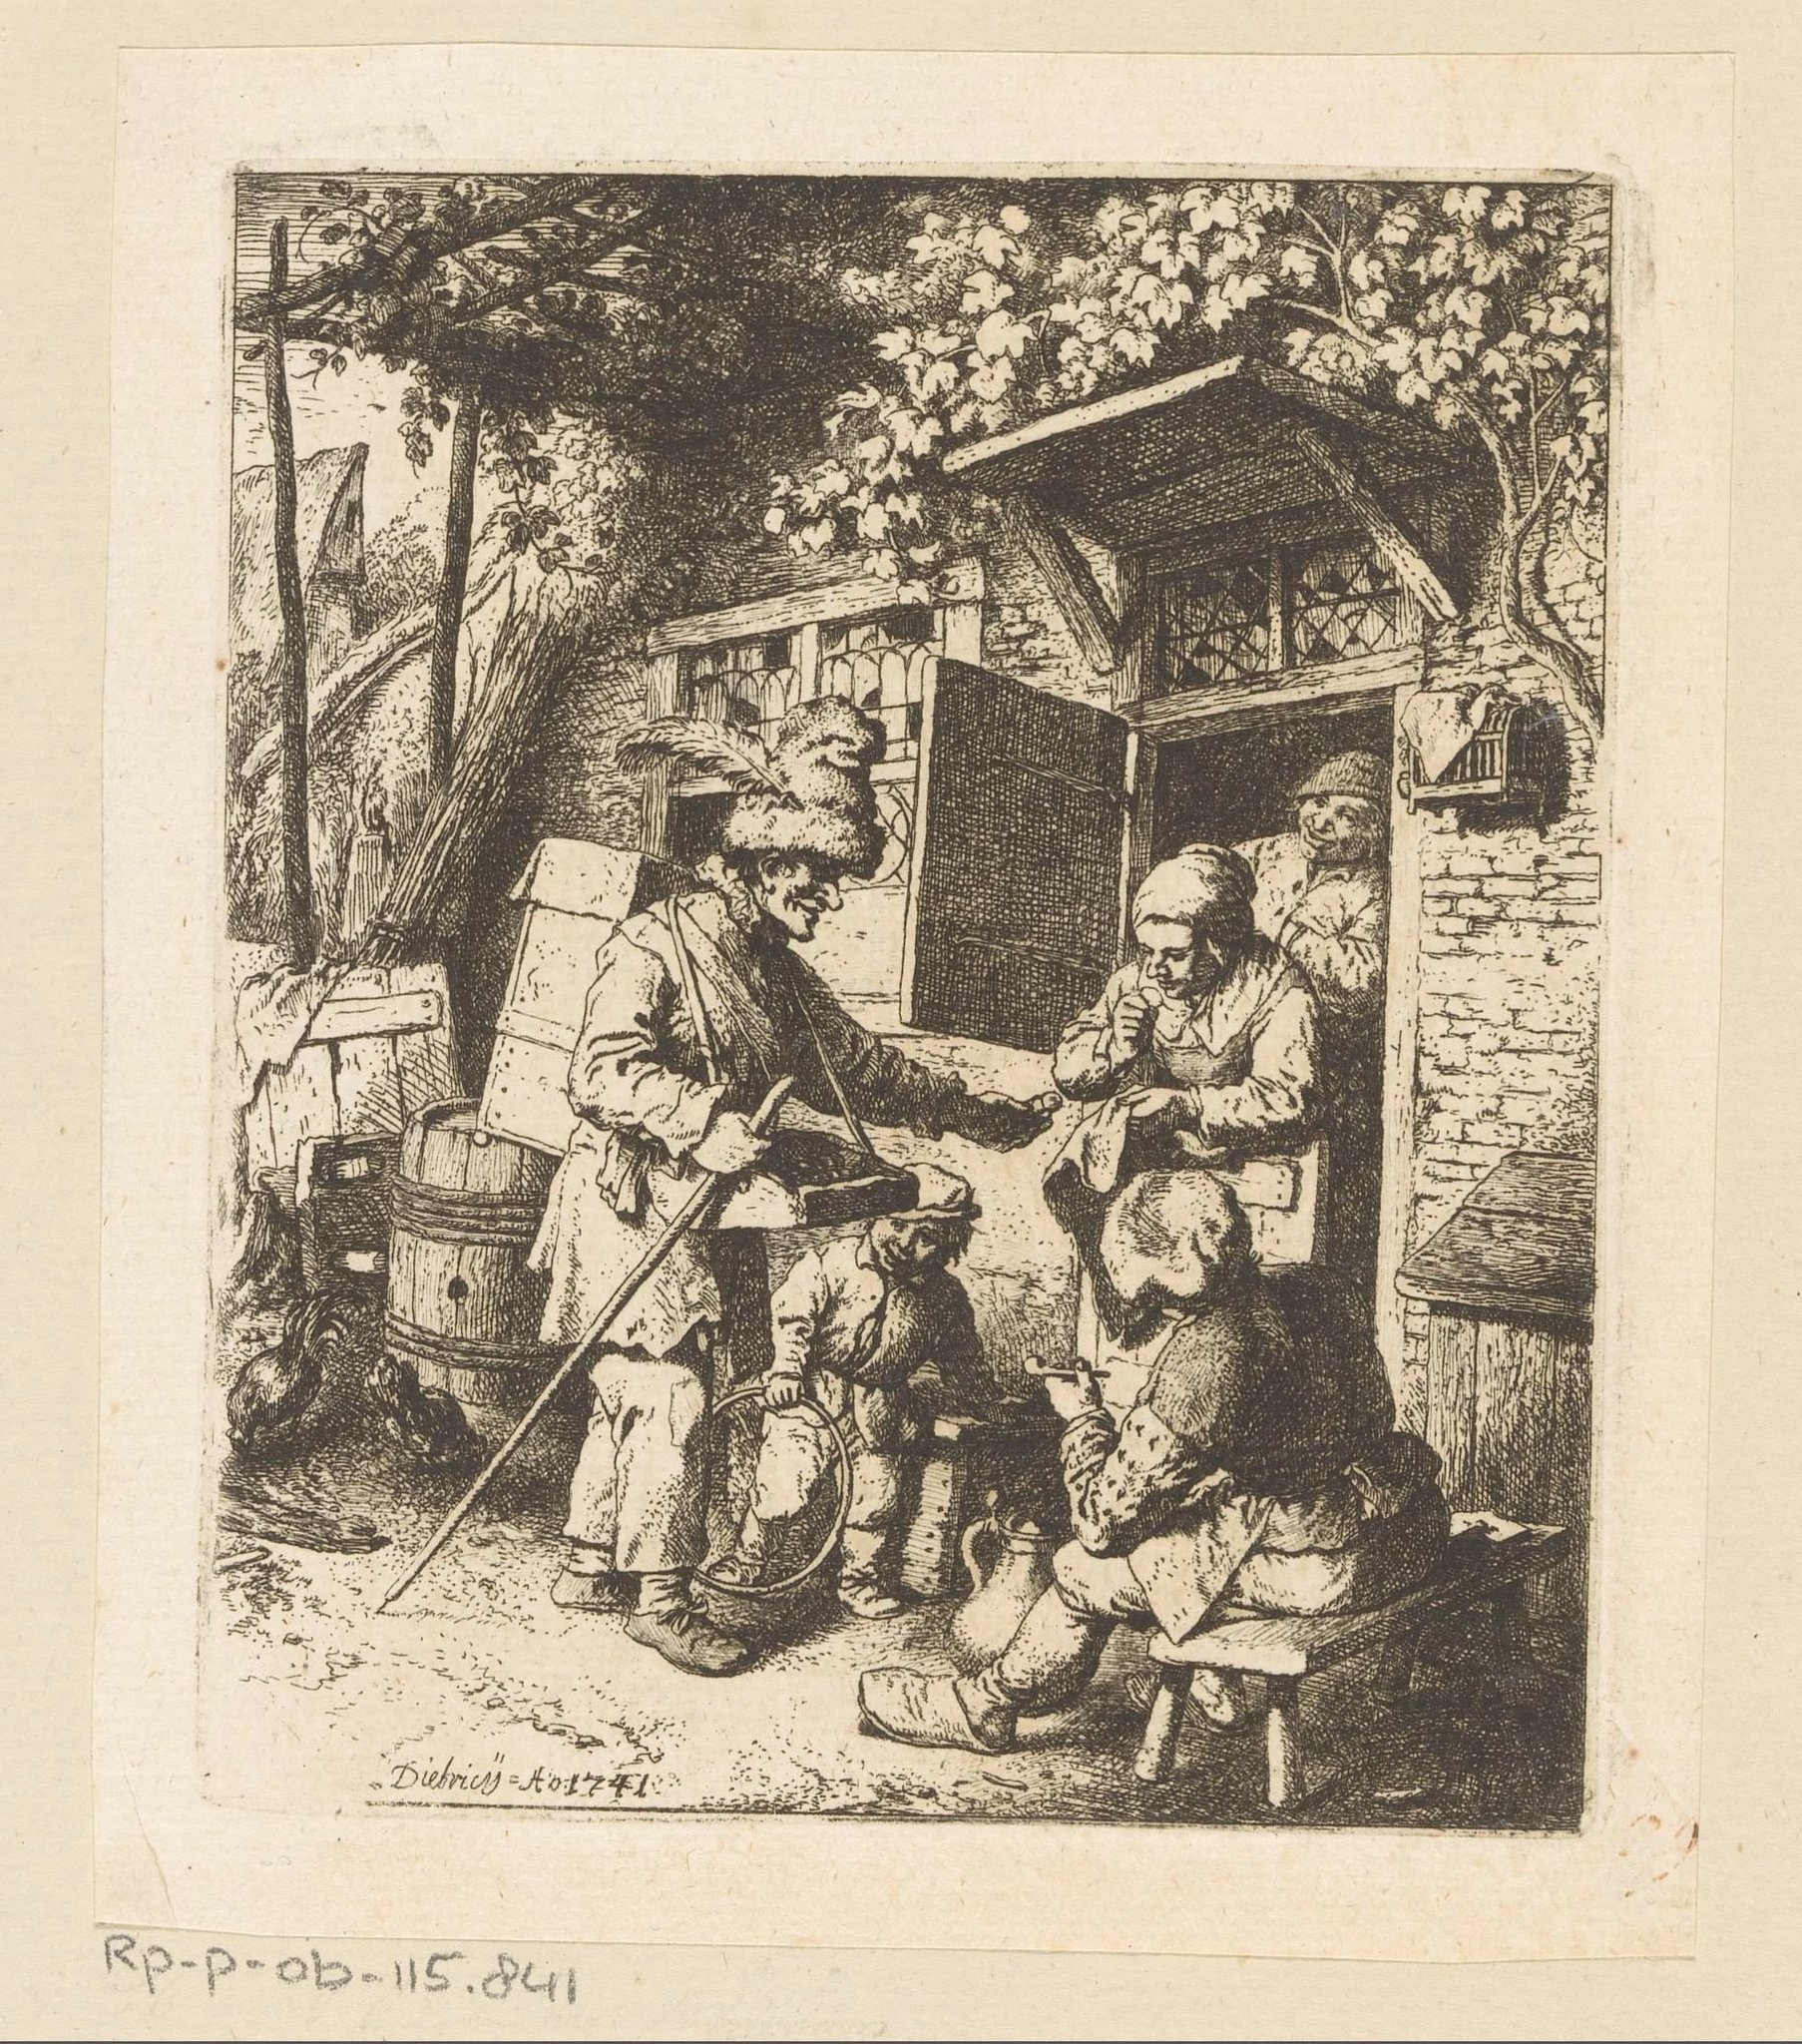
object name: print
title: Marskramer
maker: christian wilhelm ernst dietrich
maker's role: artist, painter, print maker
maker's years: 1712-1774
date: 1741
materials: paper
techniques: etching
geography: dresden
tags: city-view, and landscape with man-made constructions, farmers, pedlar, divided door, upper part opened, (bowling a) hoop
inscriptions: collector's mark: Lugt 240